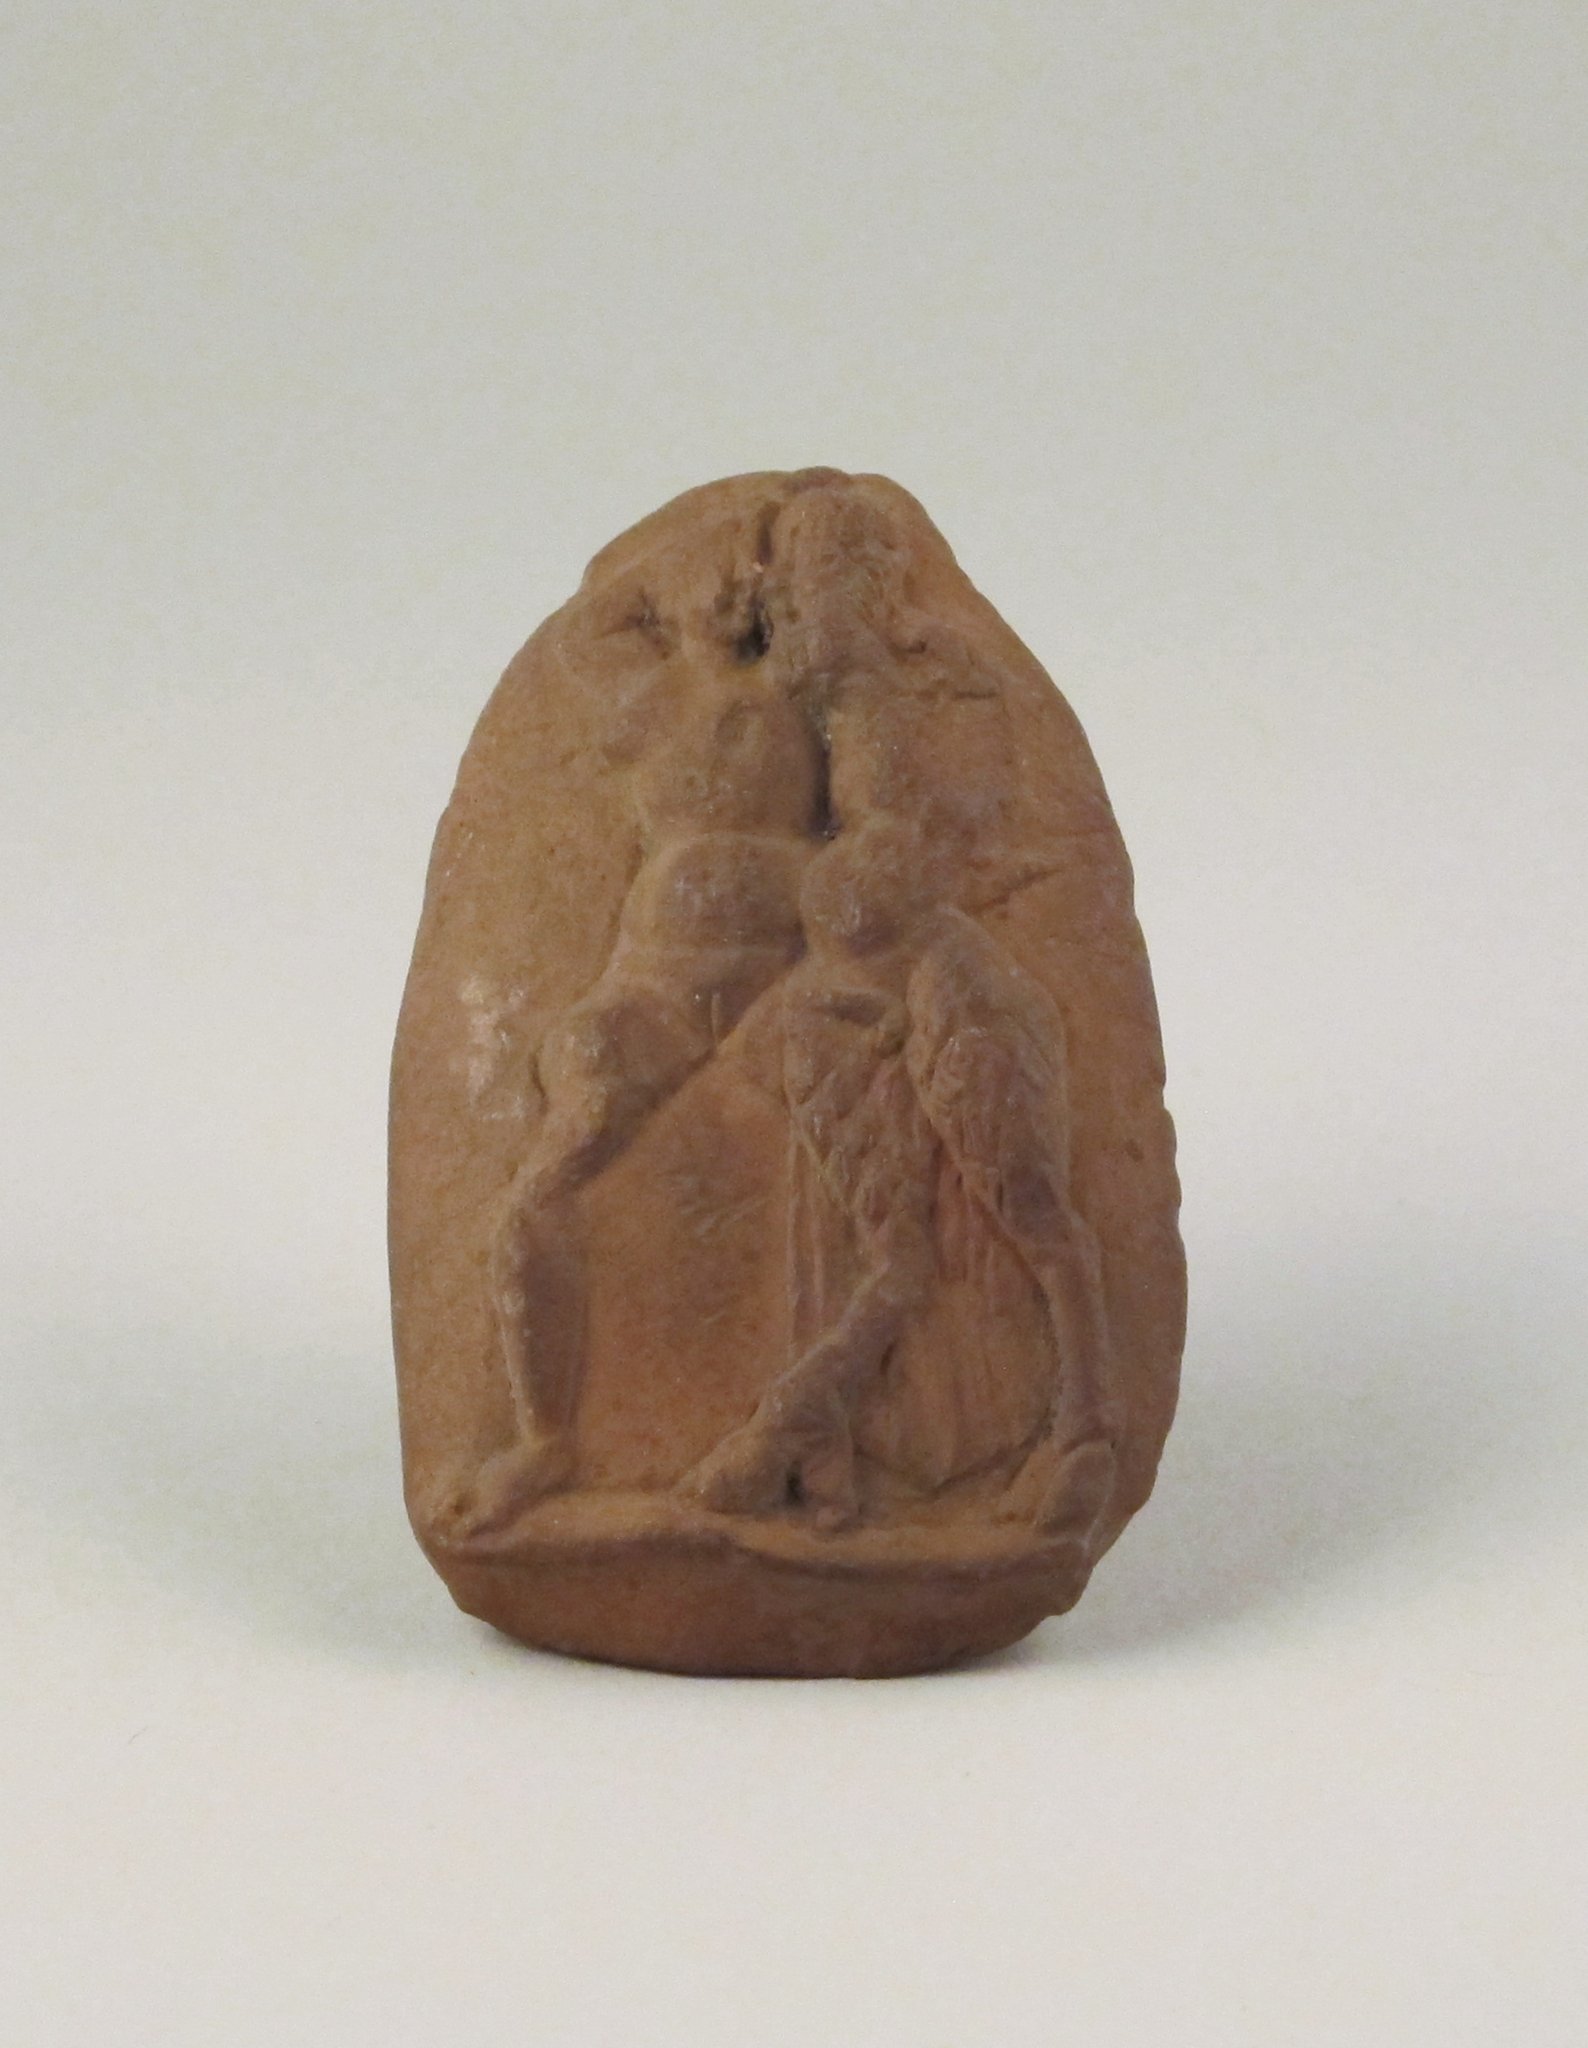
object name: potter's stamp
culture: roman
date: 670 BCE-330 CE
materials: terracotta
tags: nymphs